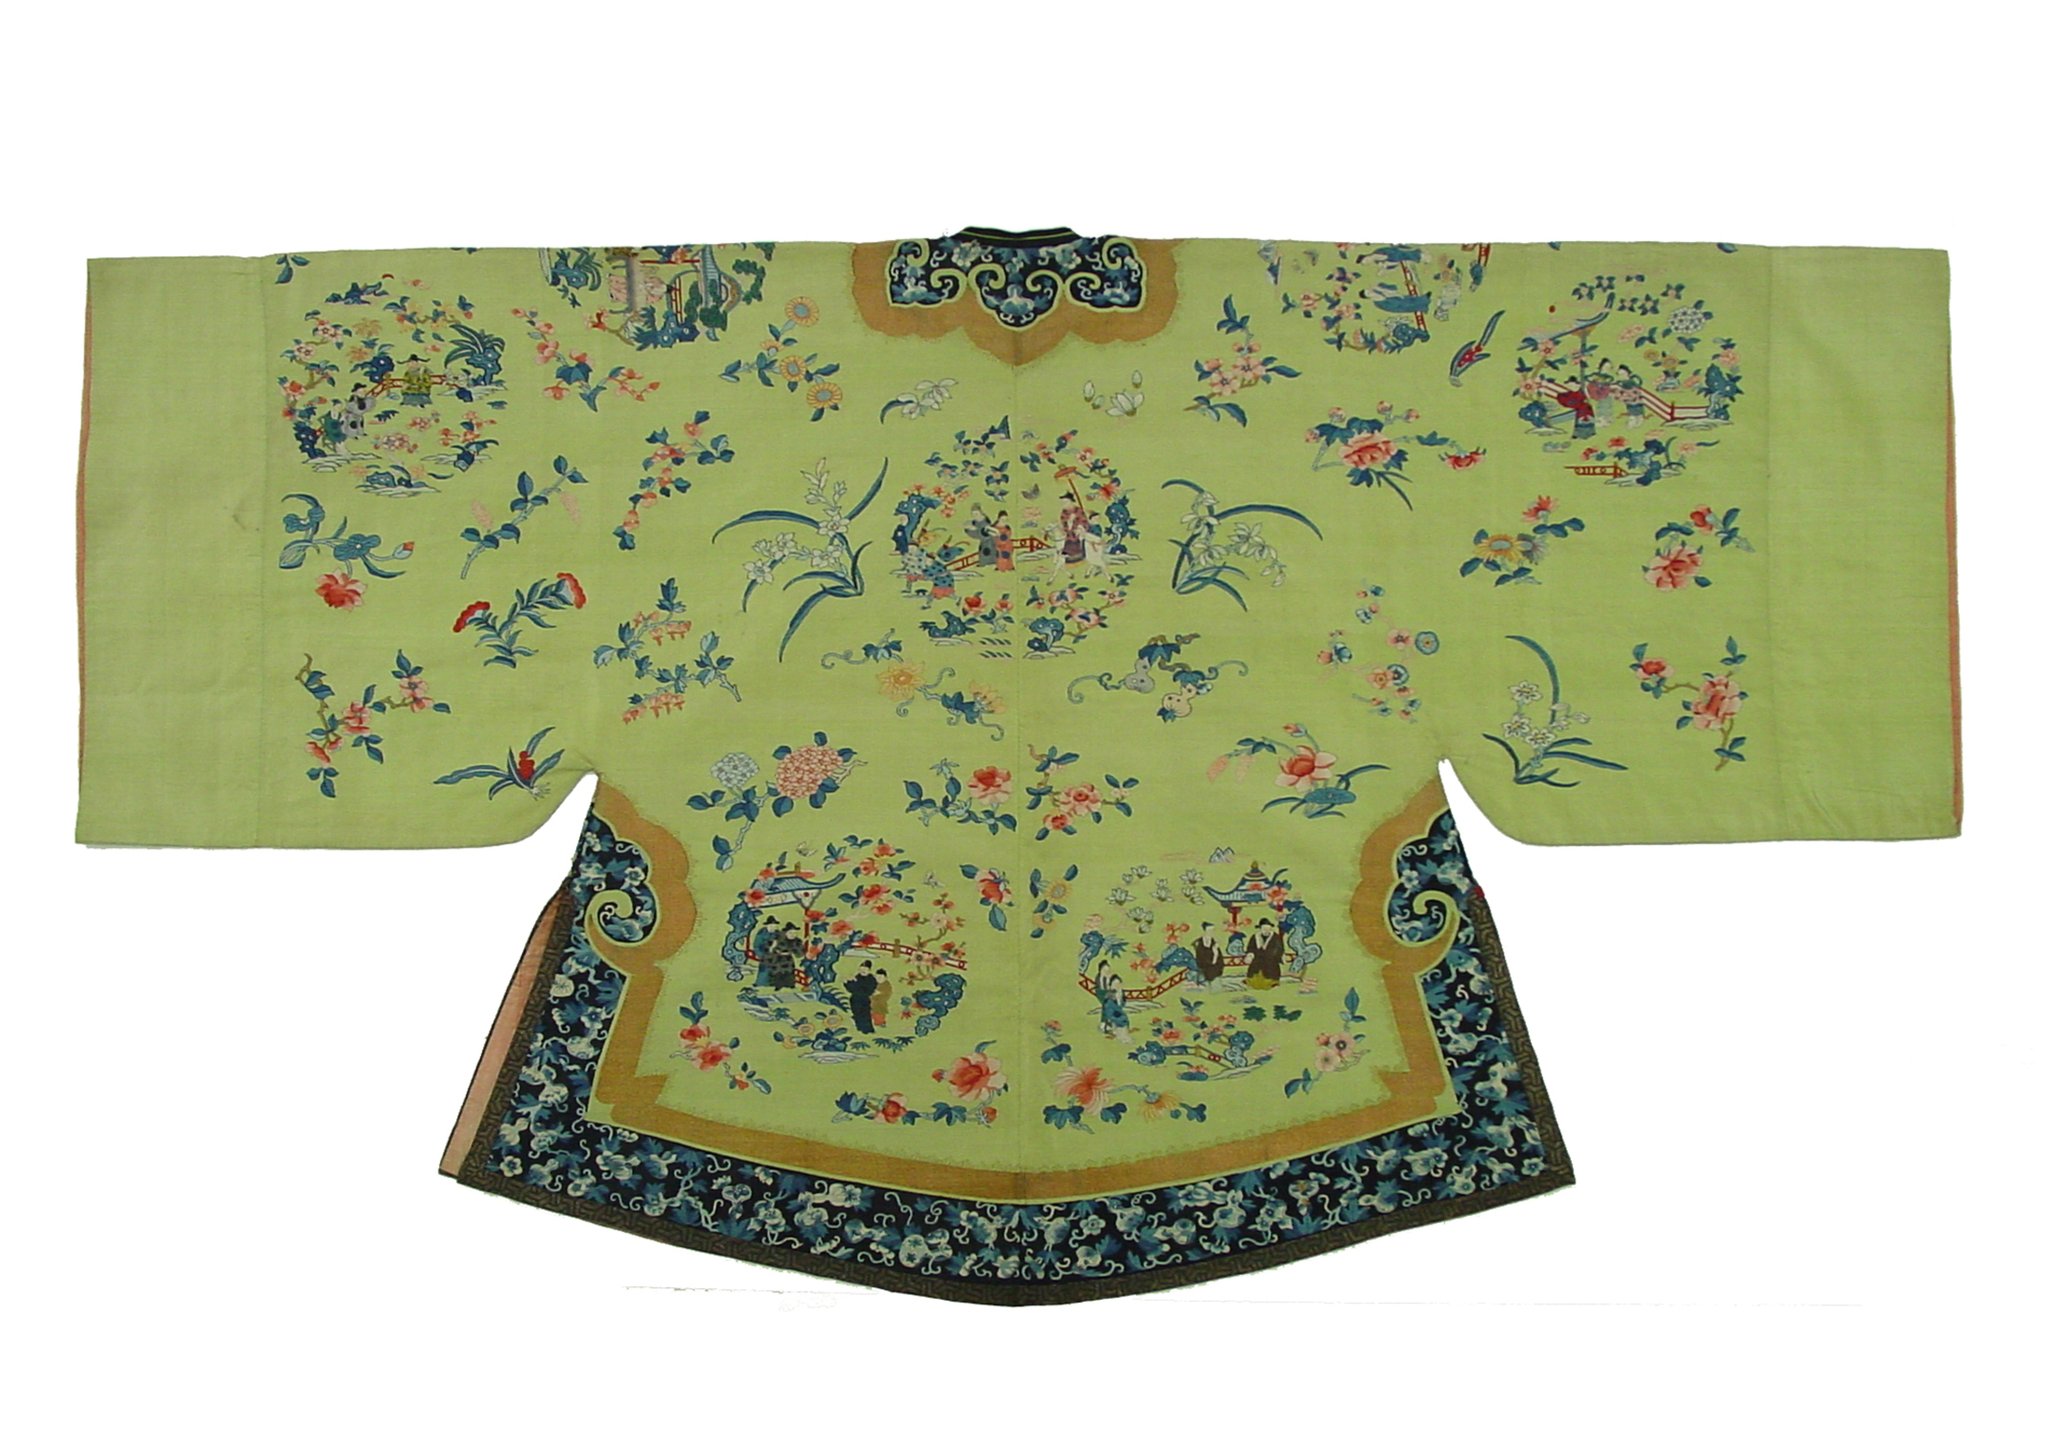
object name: jacket, lady's short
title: Lady's Short Jacket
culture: chinese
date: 1834-1866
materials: silk